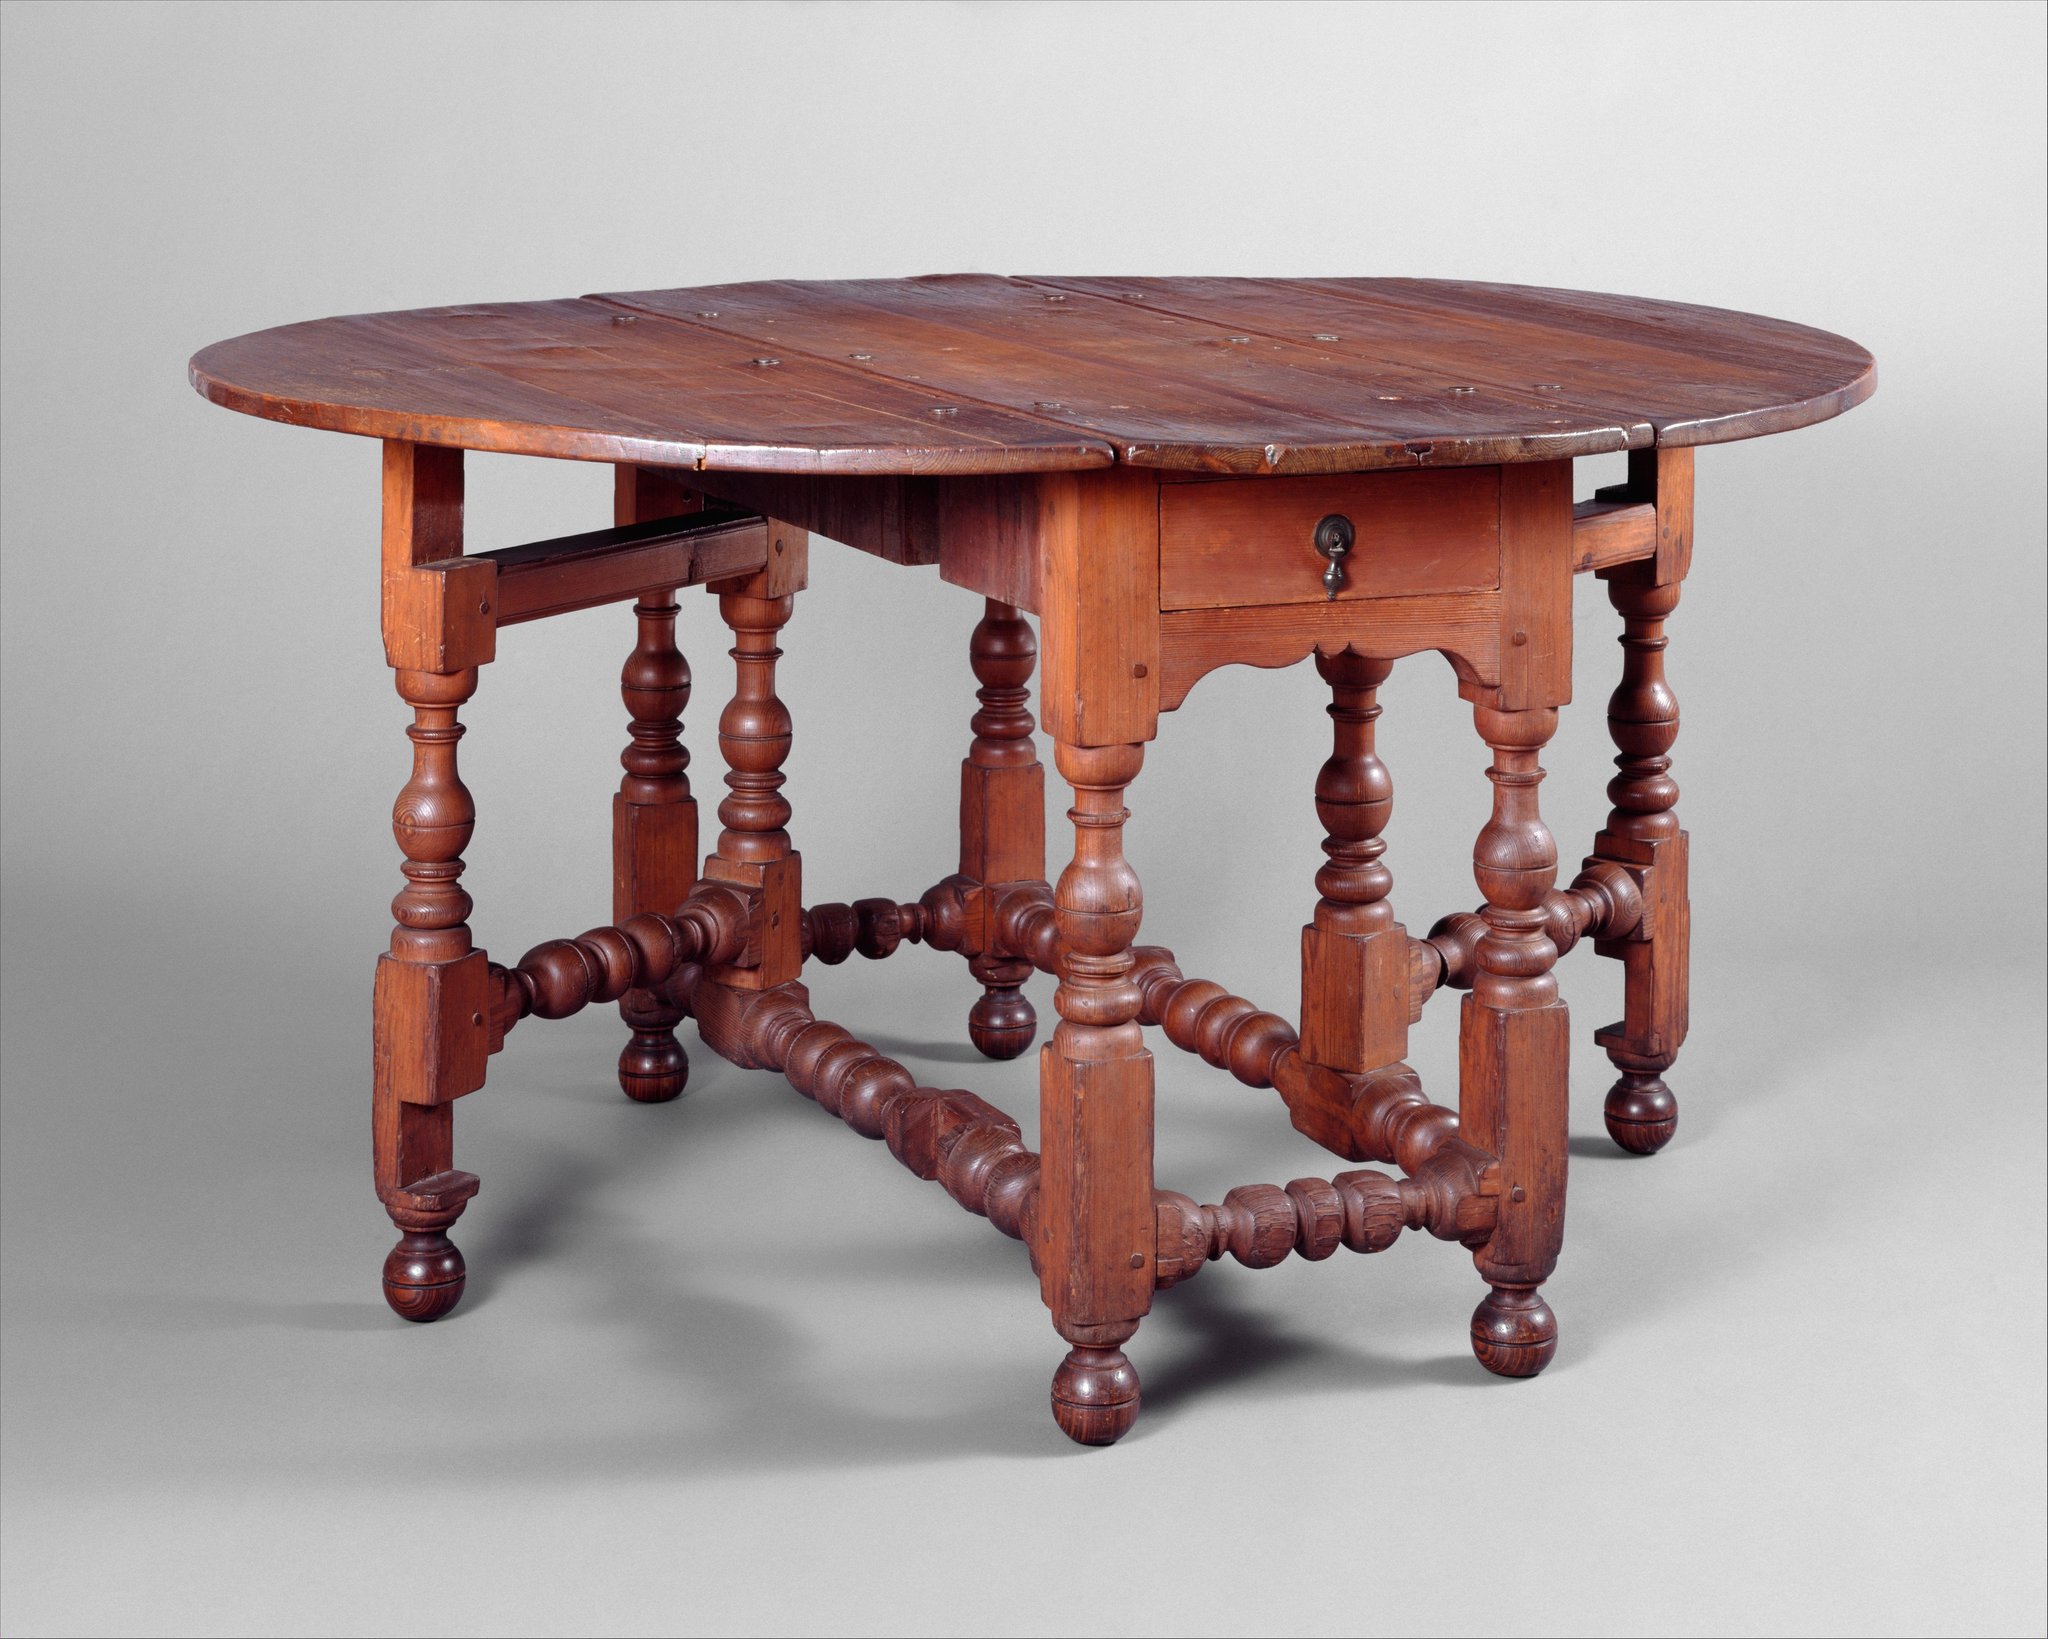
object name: gate leg drop leaf table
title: Gate-leg Drop-leaf Table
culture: american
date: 1700-1750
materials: wood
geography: united states